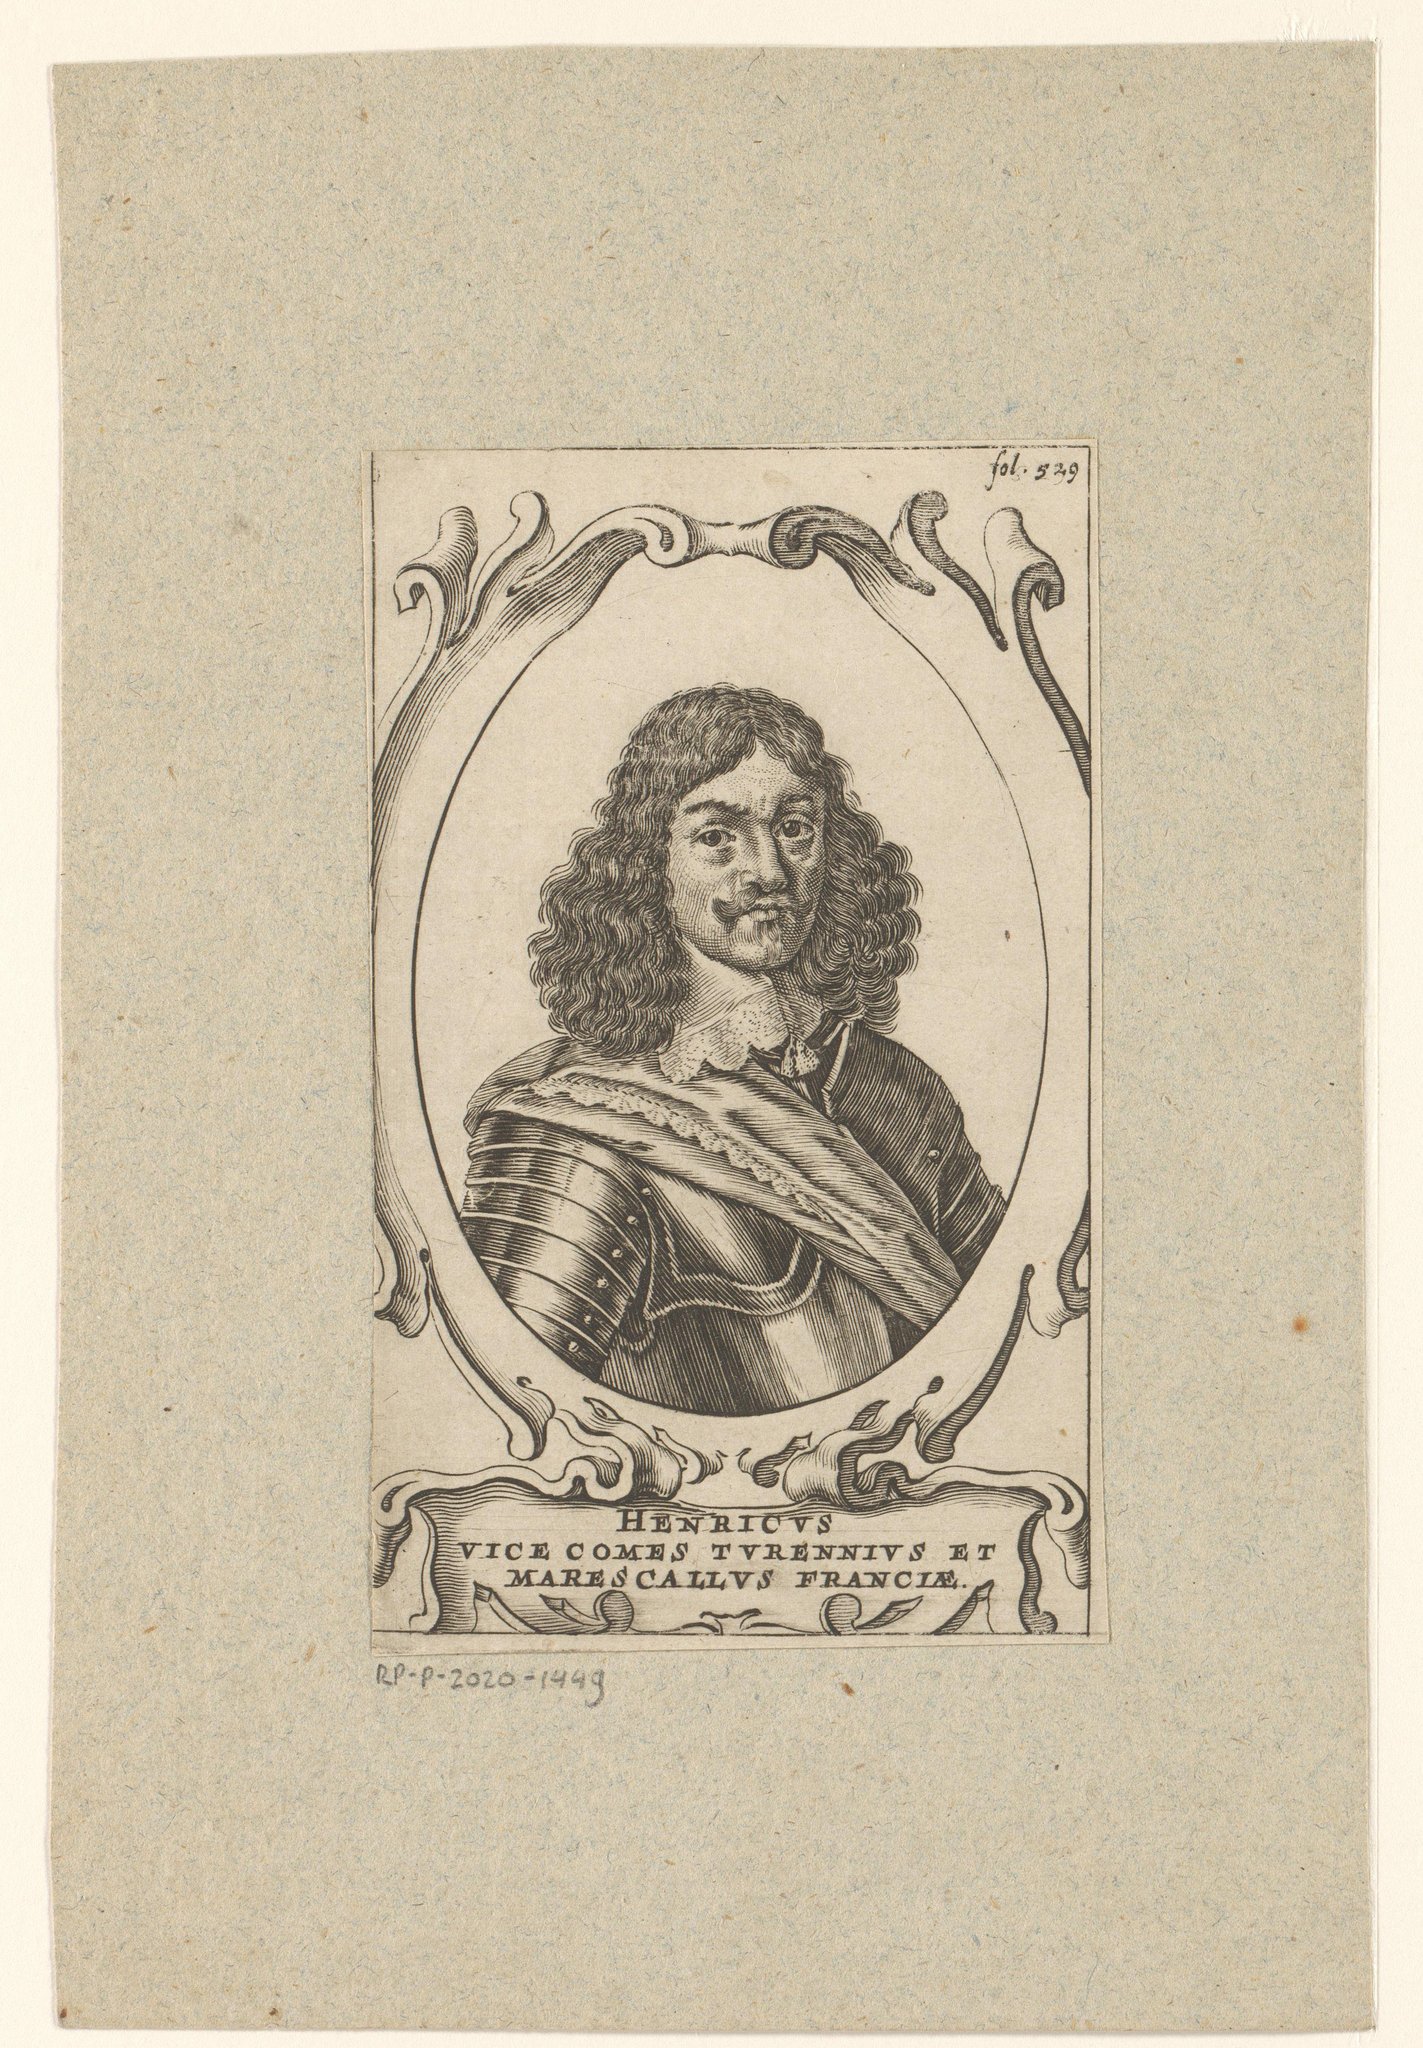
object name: print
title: Henricus vice comes Turennius et mares callus Franciae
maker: Anonymous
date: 1656-1666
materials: paper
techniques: engraving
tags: commander-in-chief, general, marshal, historical persons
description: Prent gebruikt in: Brachelius, Johannes Adolphus. Historia nostri temporis, dat is: geschiedenis onses tijdts, (...). Rotterdam: Andries van Hoogenhuyse, 1656. Prent in ieder geval ook gebruikt in hetzelfde boek uitgegeven door Andries van Hoogenhuyse in Nijmegen in 1659 en uitgegeven door Samuel Imbrecht in Amsterdam in 1666.